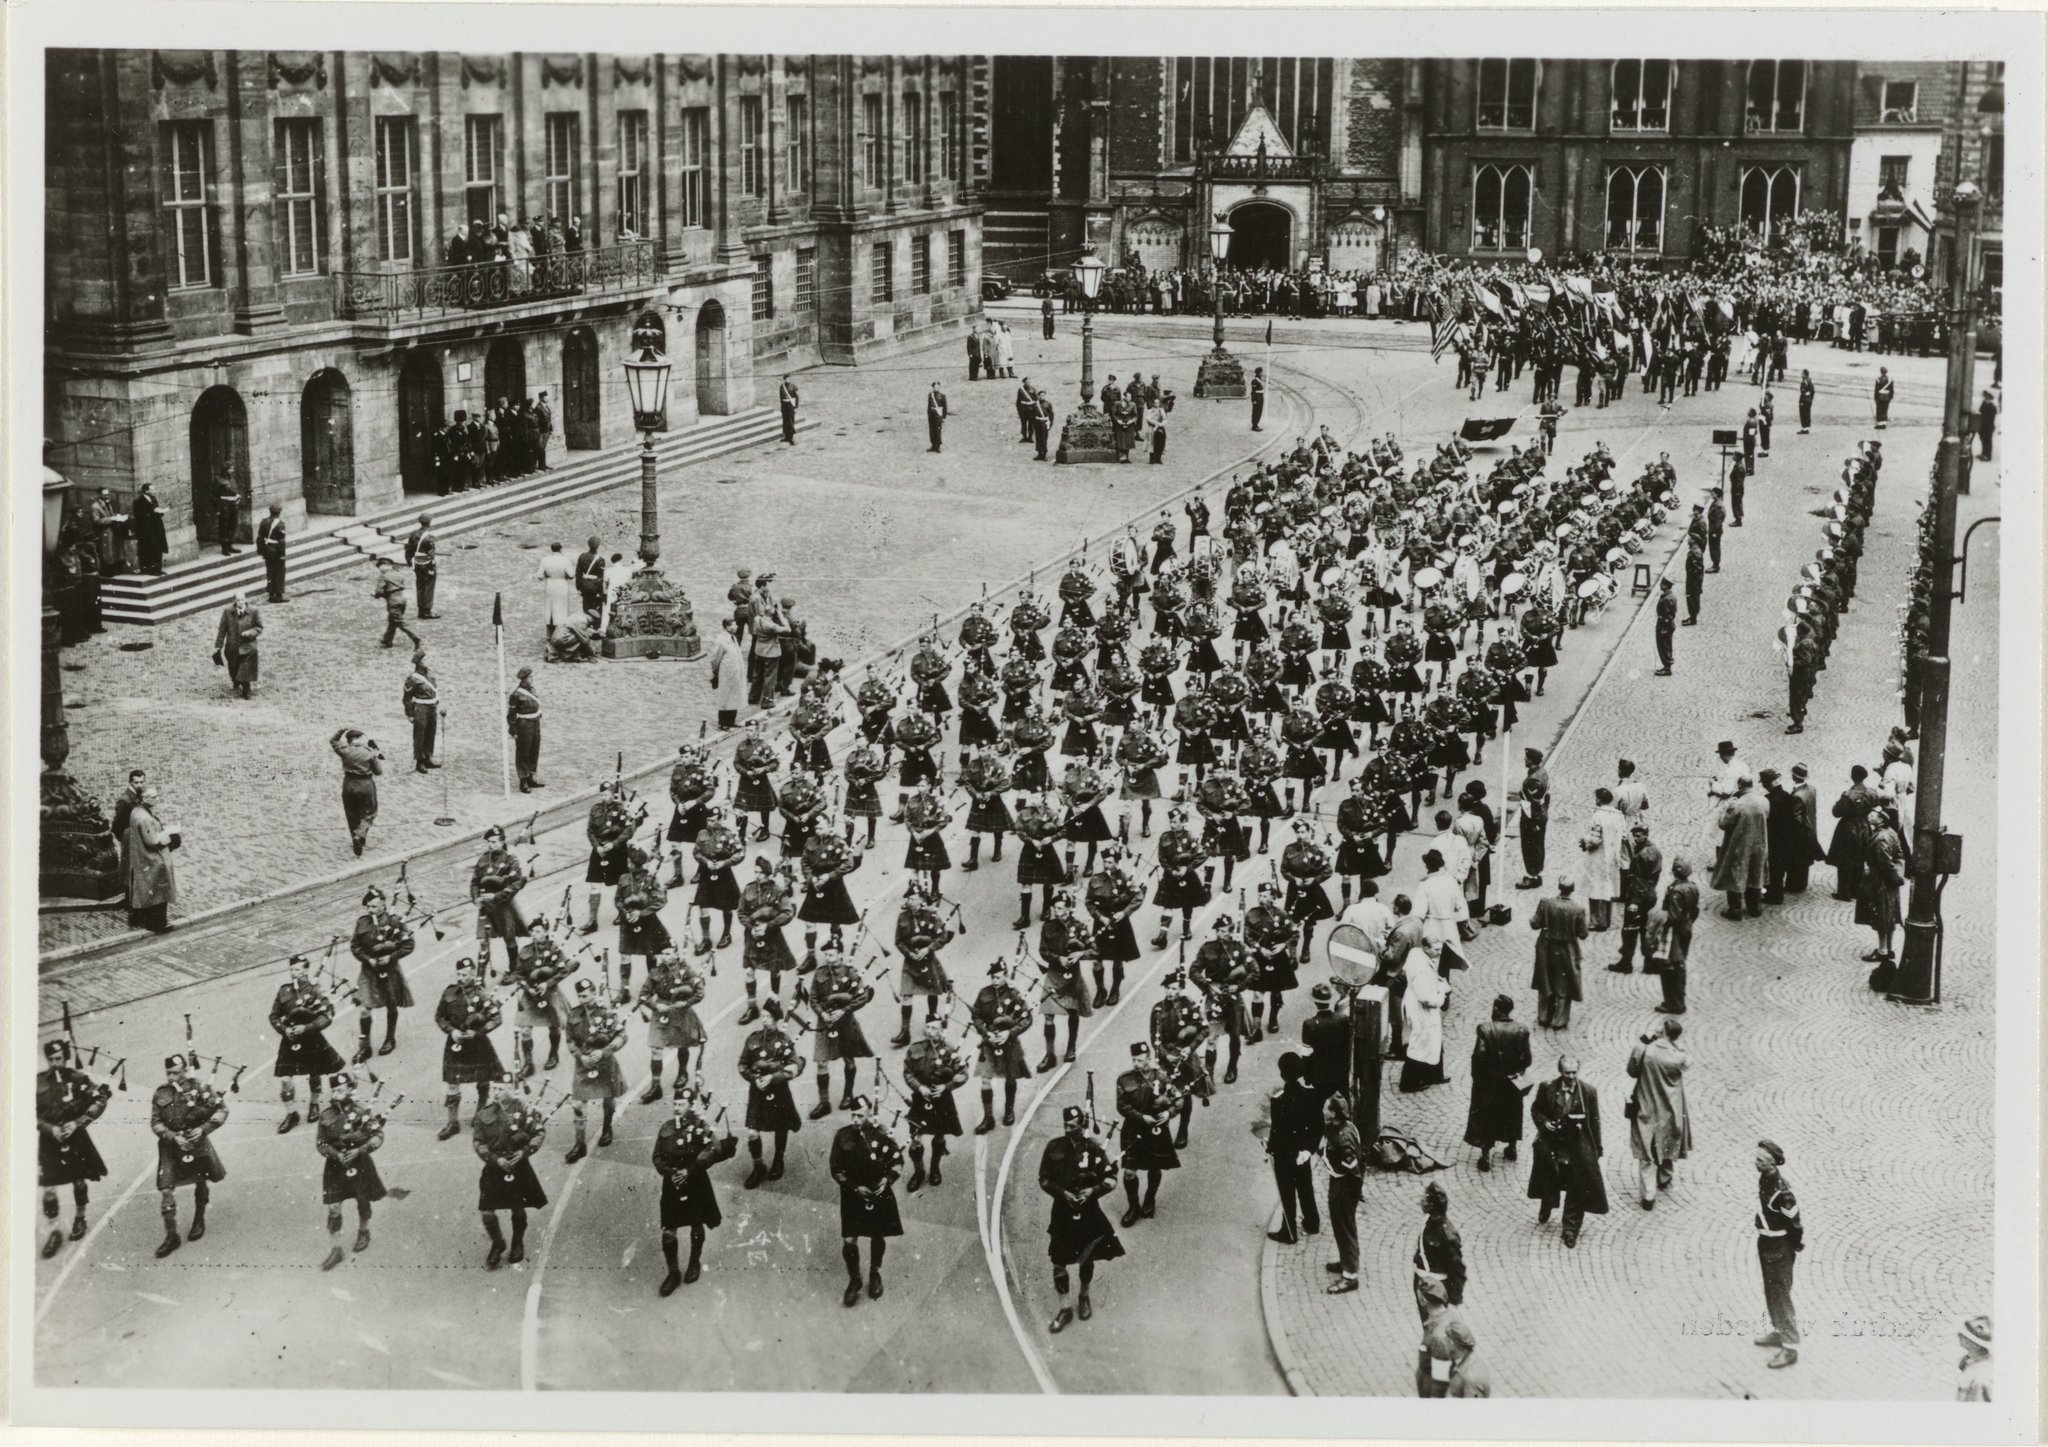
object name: ansichtkaart, prentbriefkaart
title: Schotse doedelzakspelers in het defilé op de Dam te Amsterdam bij de bevrijdingsfeesten op 28 juni 1945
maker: noordhoff. e.j.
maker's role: fotograaf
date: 1945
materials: photographic support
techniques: photography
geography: amsterdam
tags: the hague, print maker, wilhelmina of the netherlands